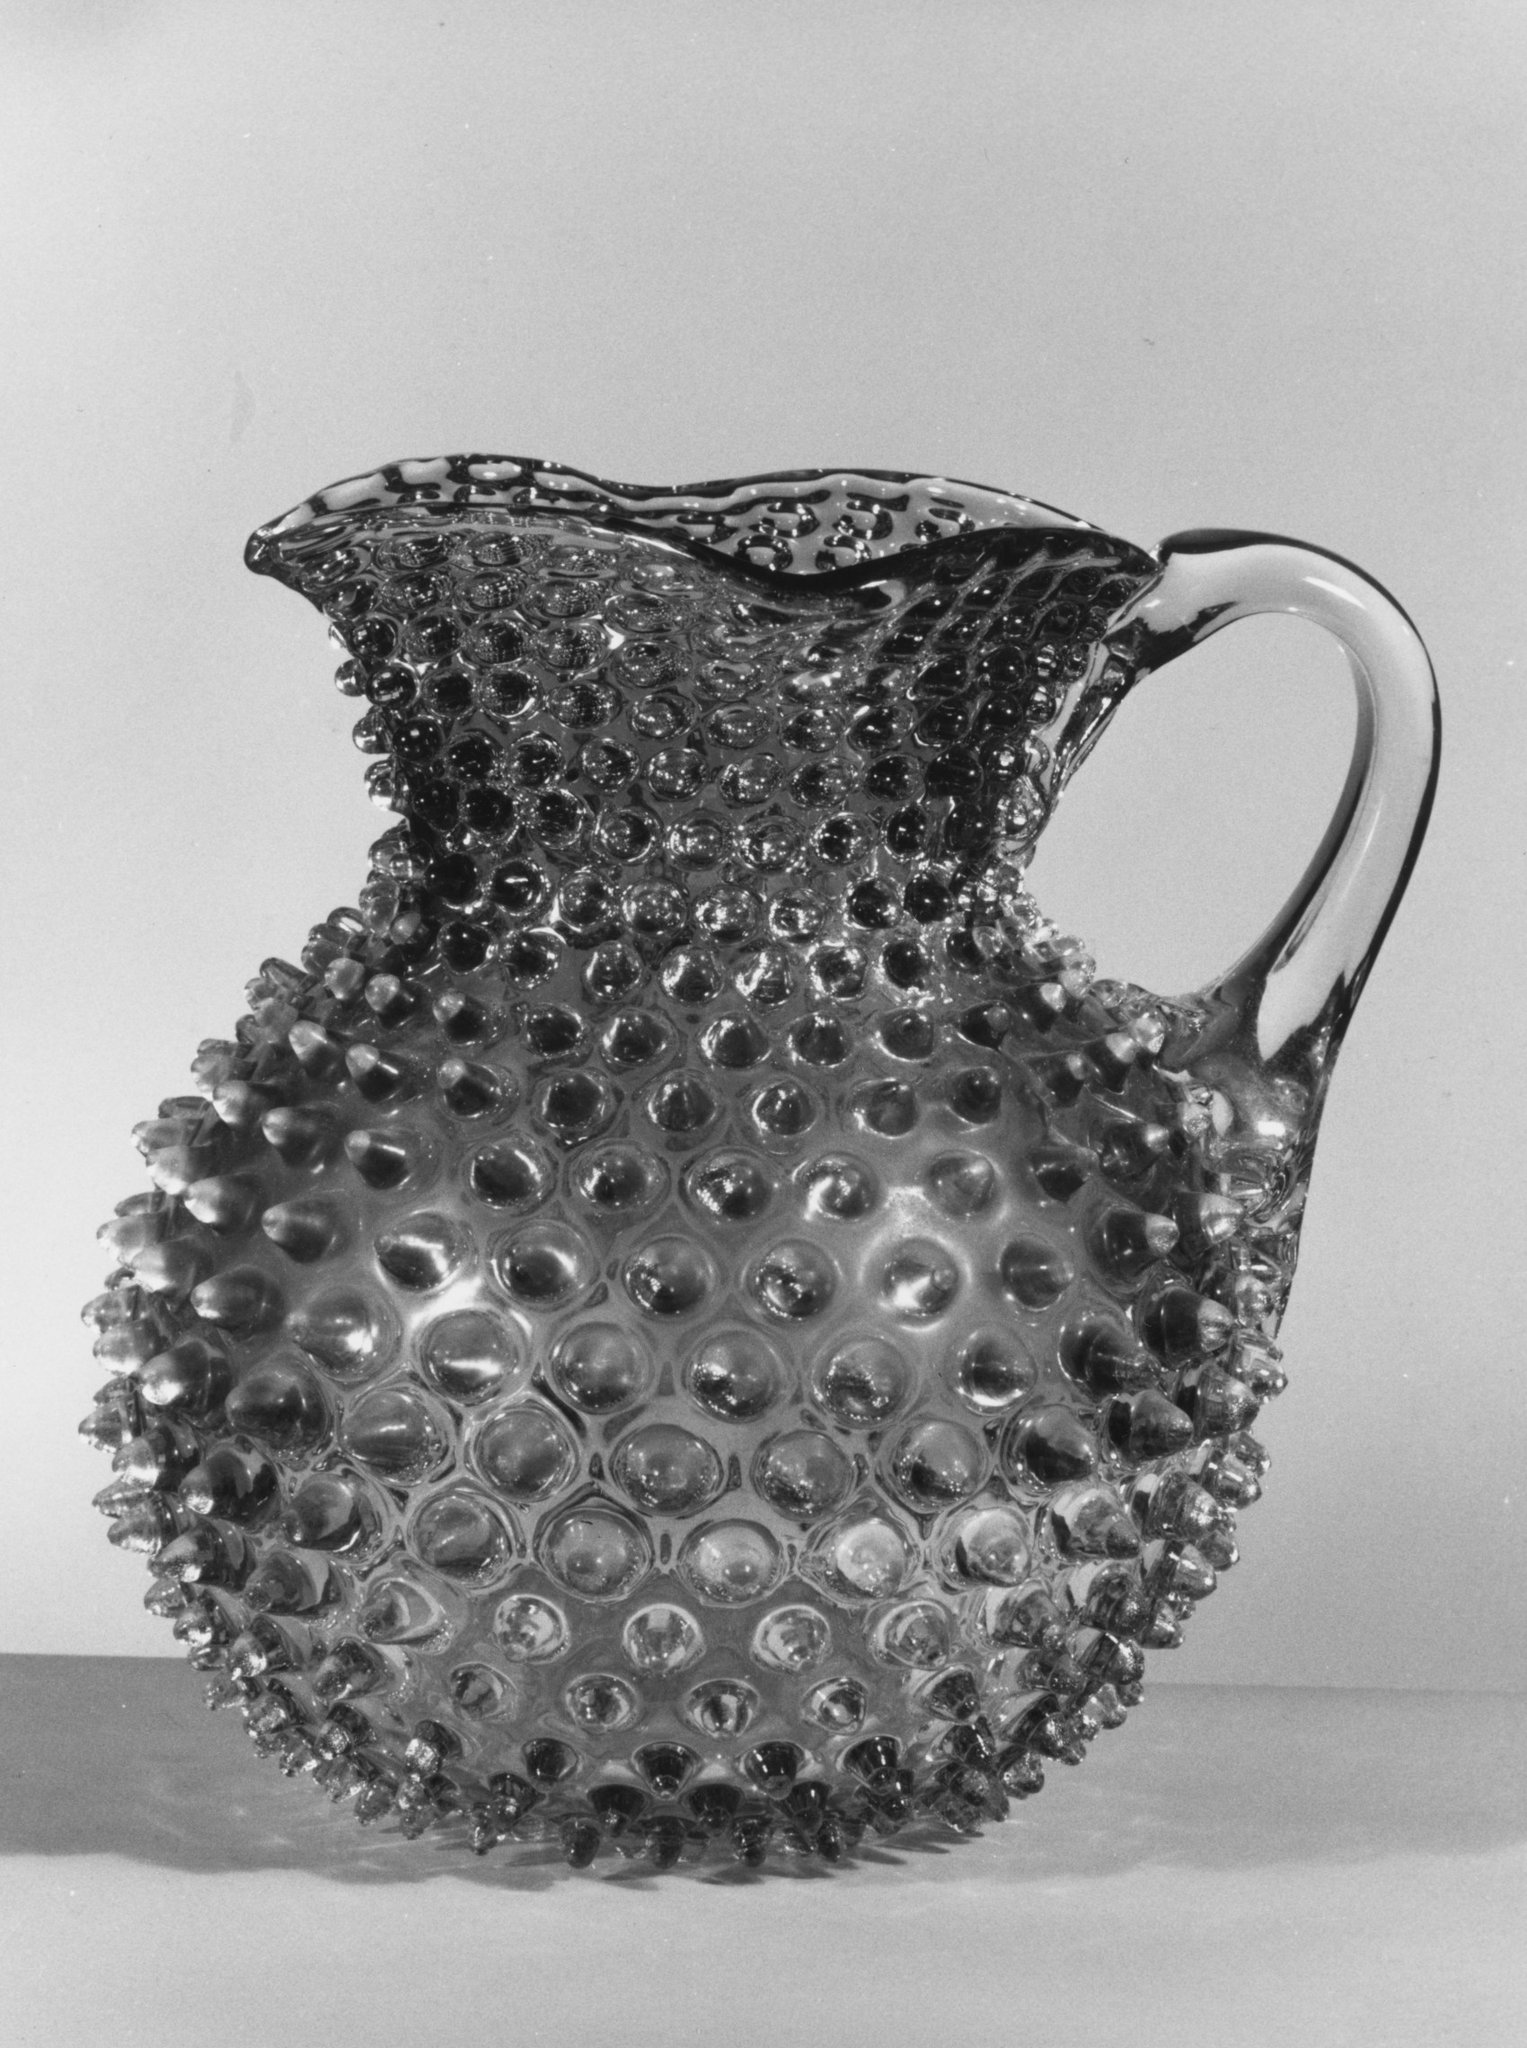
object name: pitcher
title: Hobnail Pitcher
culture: american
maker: hobbs, brockunier and company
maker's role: maker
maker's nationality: american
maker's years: 1863-1891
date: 1886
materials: glass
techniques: pressed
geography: united states